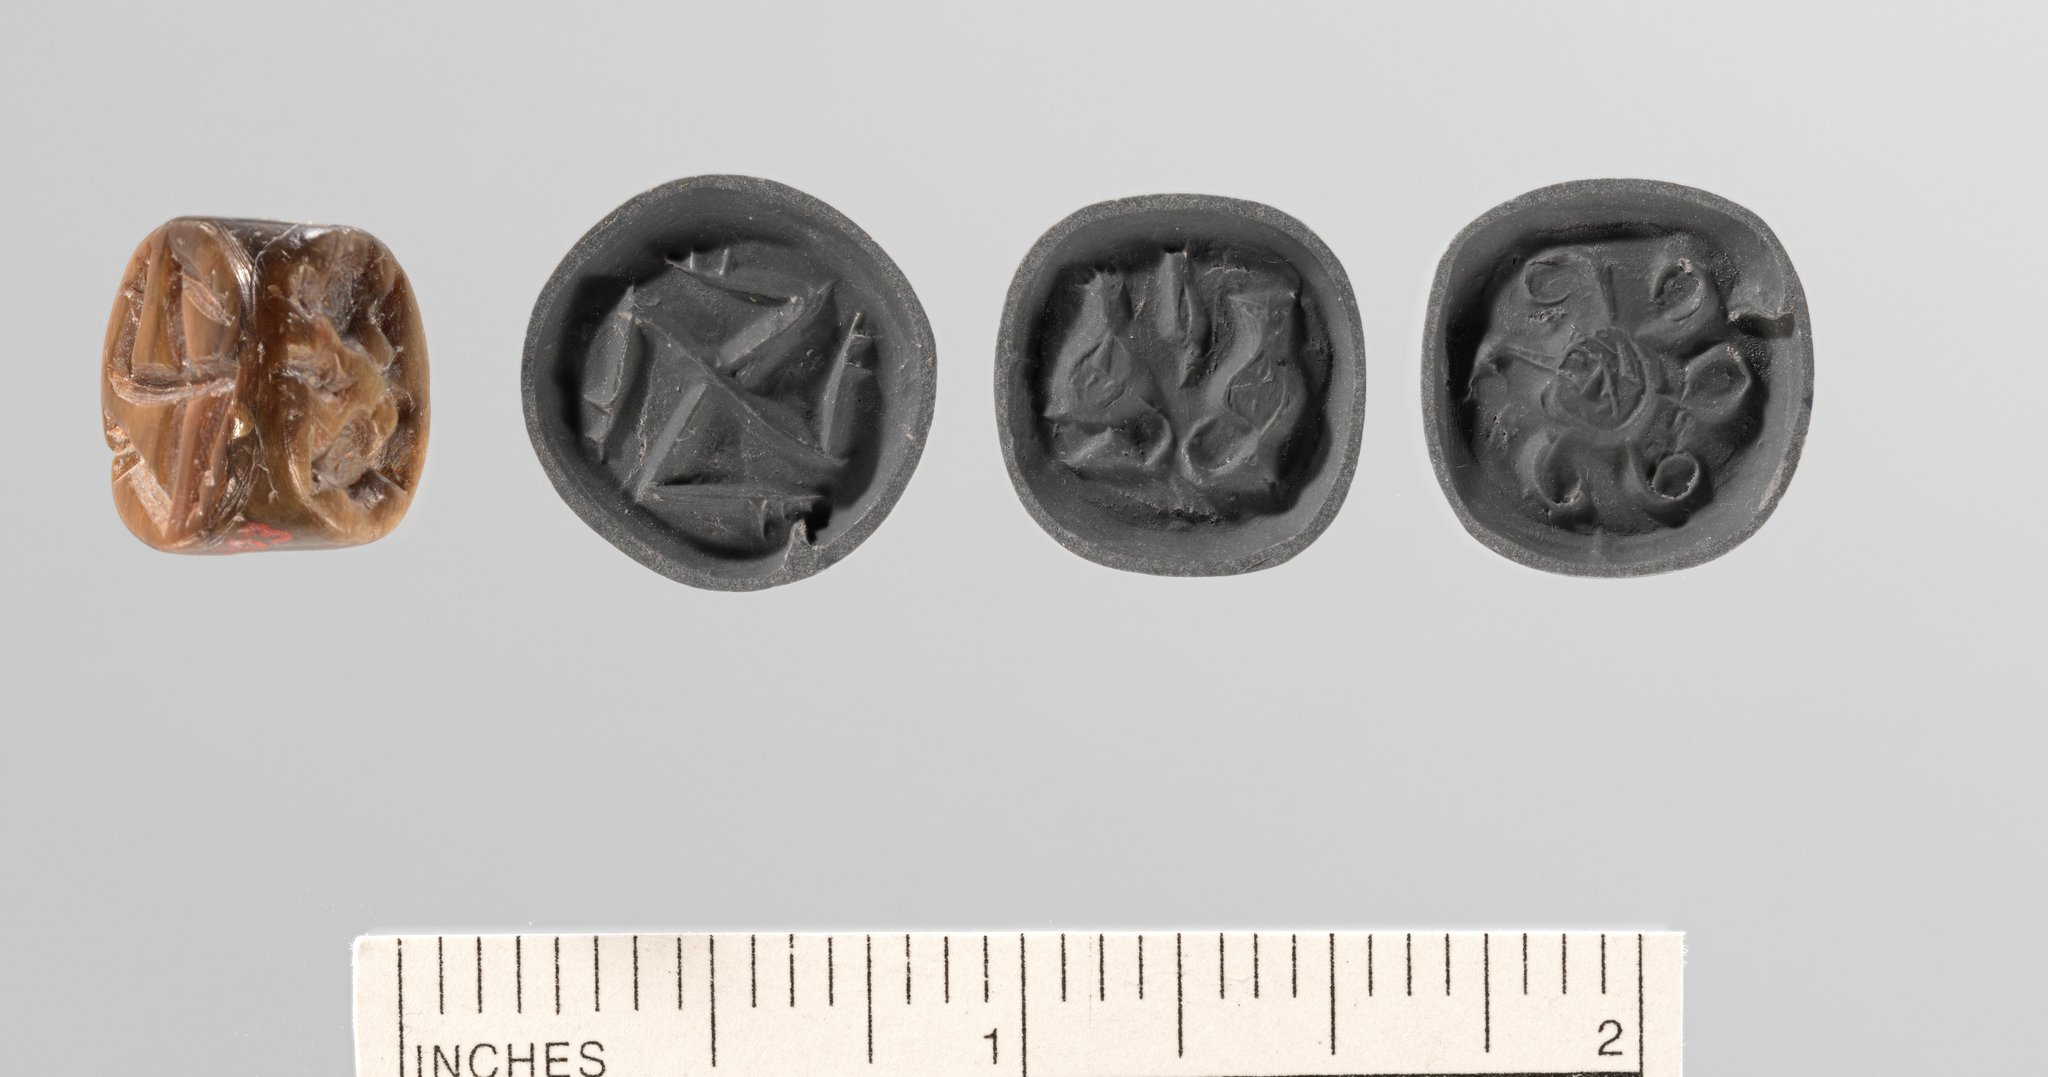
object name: prism, triangular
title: Serpentine Triangular Prism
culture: minoan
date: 1800-1700 BCE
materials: stone